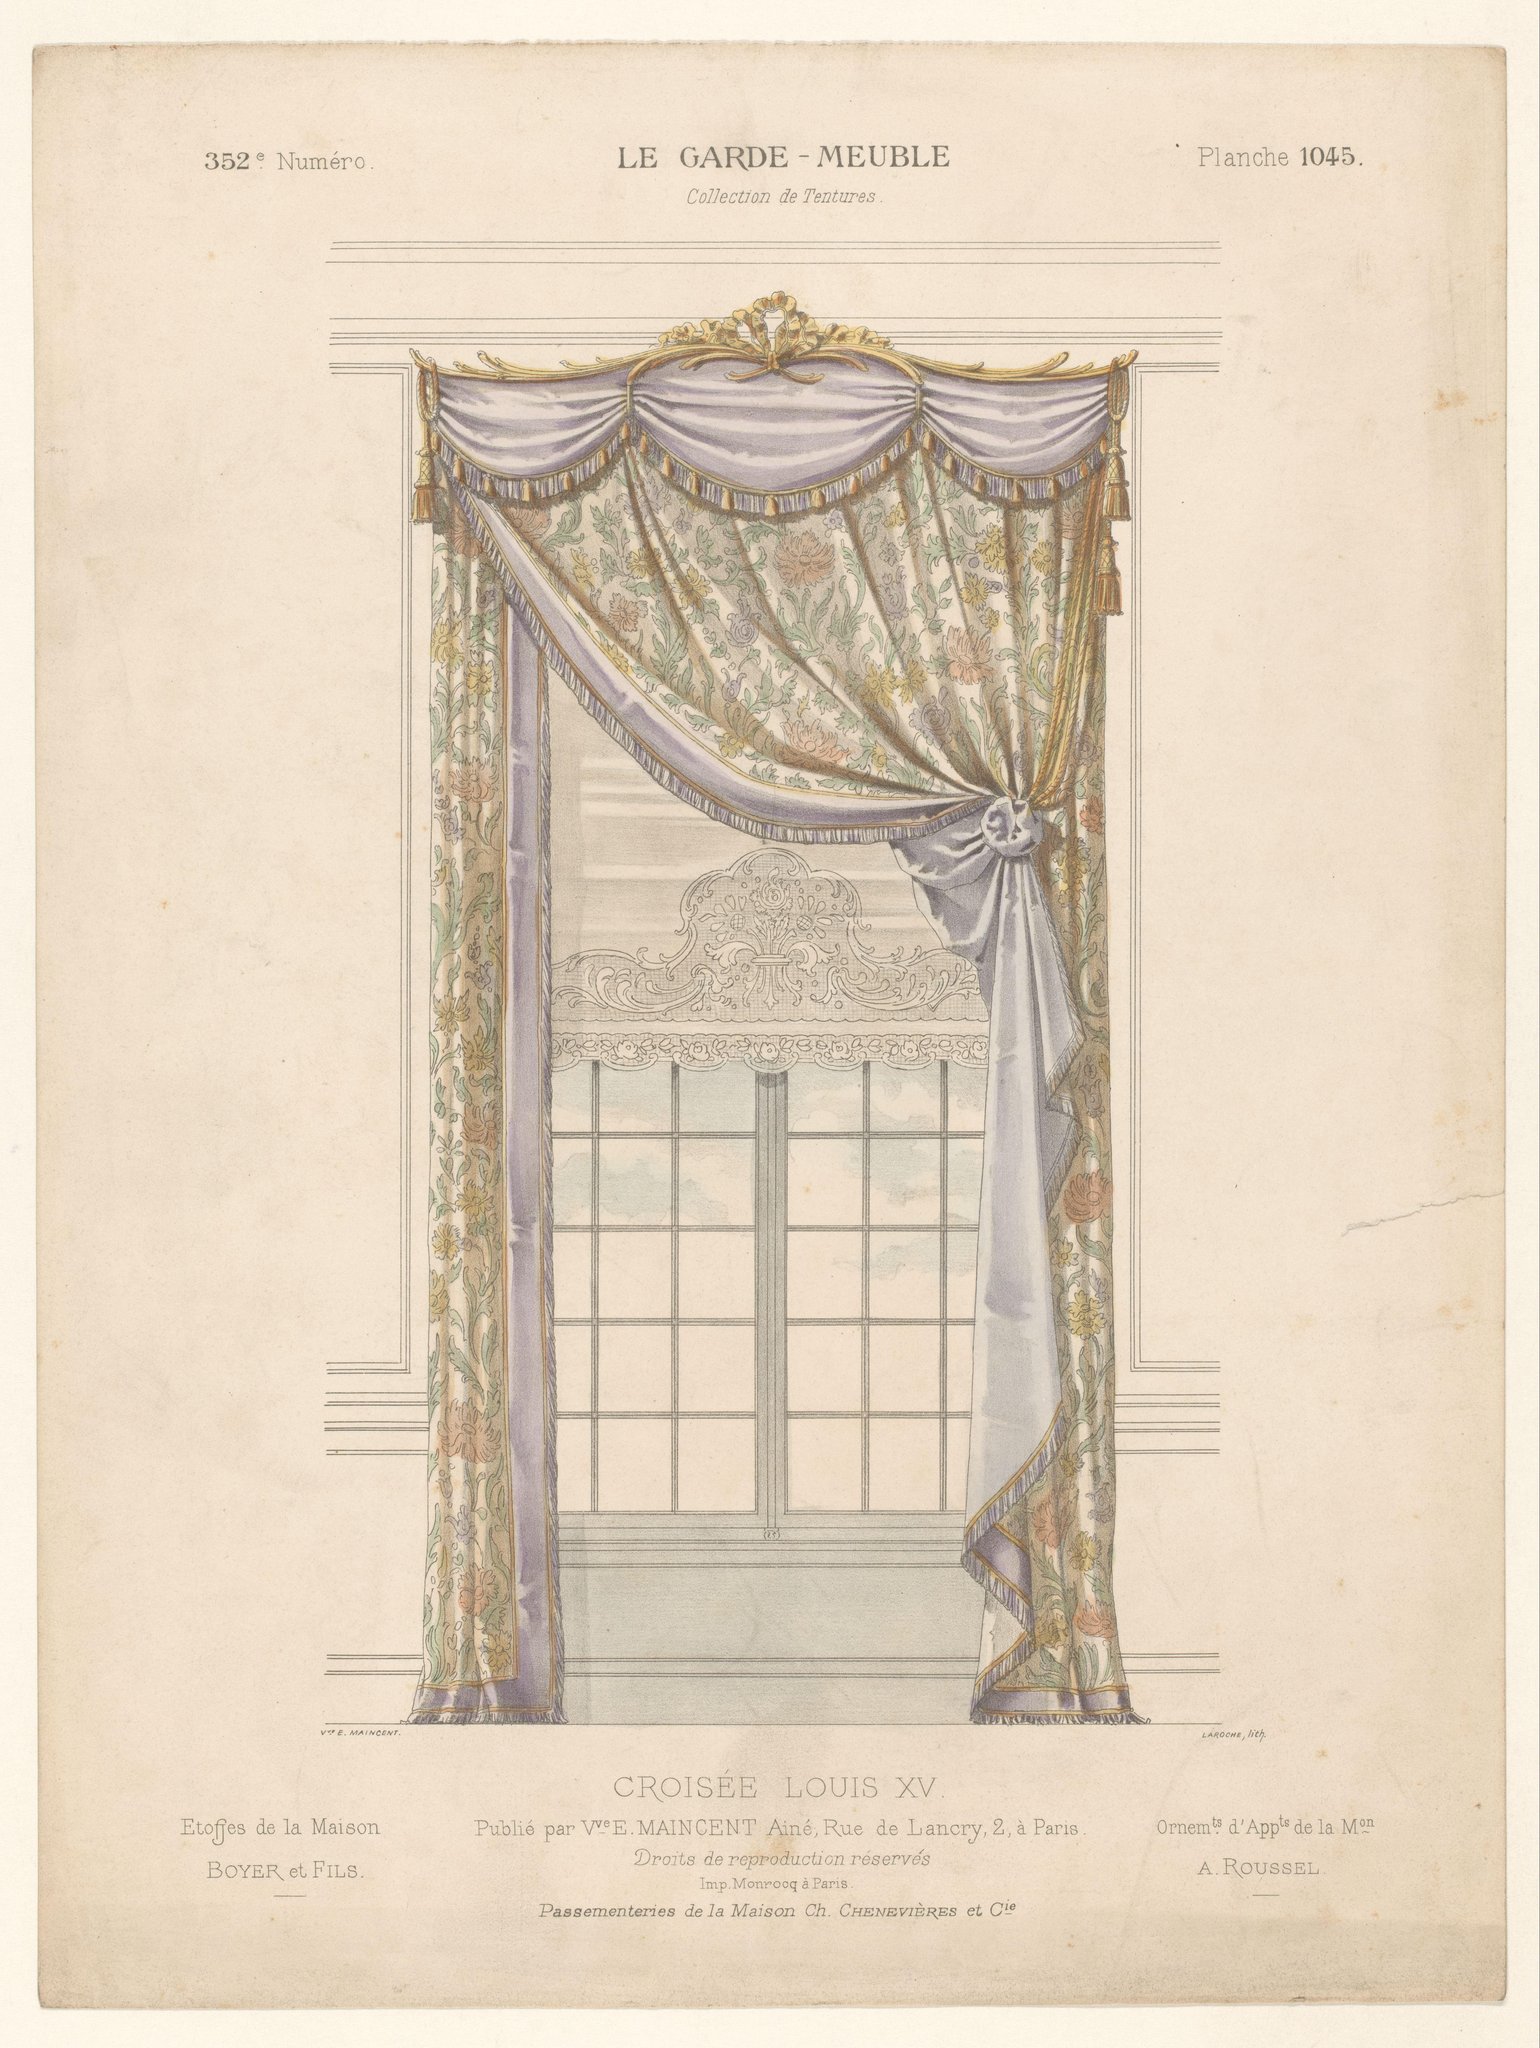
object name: print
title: Venster met gordijnen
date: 1895-1910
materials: paper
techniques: hand coloring, lithograph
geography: paris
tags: window, hangings and drapery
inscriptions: : ‘Droits de reproduction réservés.’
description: Kruisvenster met gedrapeerde gordijnen in de Lodewijk XV-stijl. Prent uit 352e Livraison.